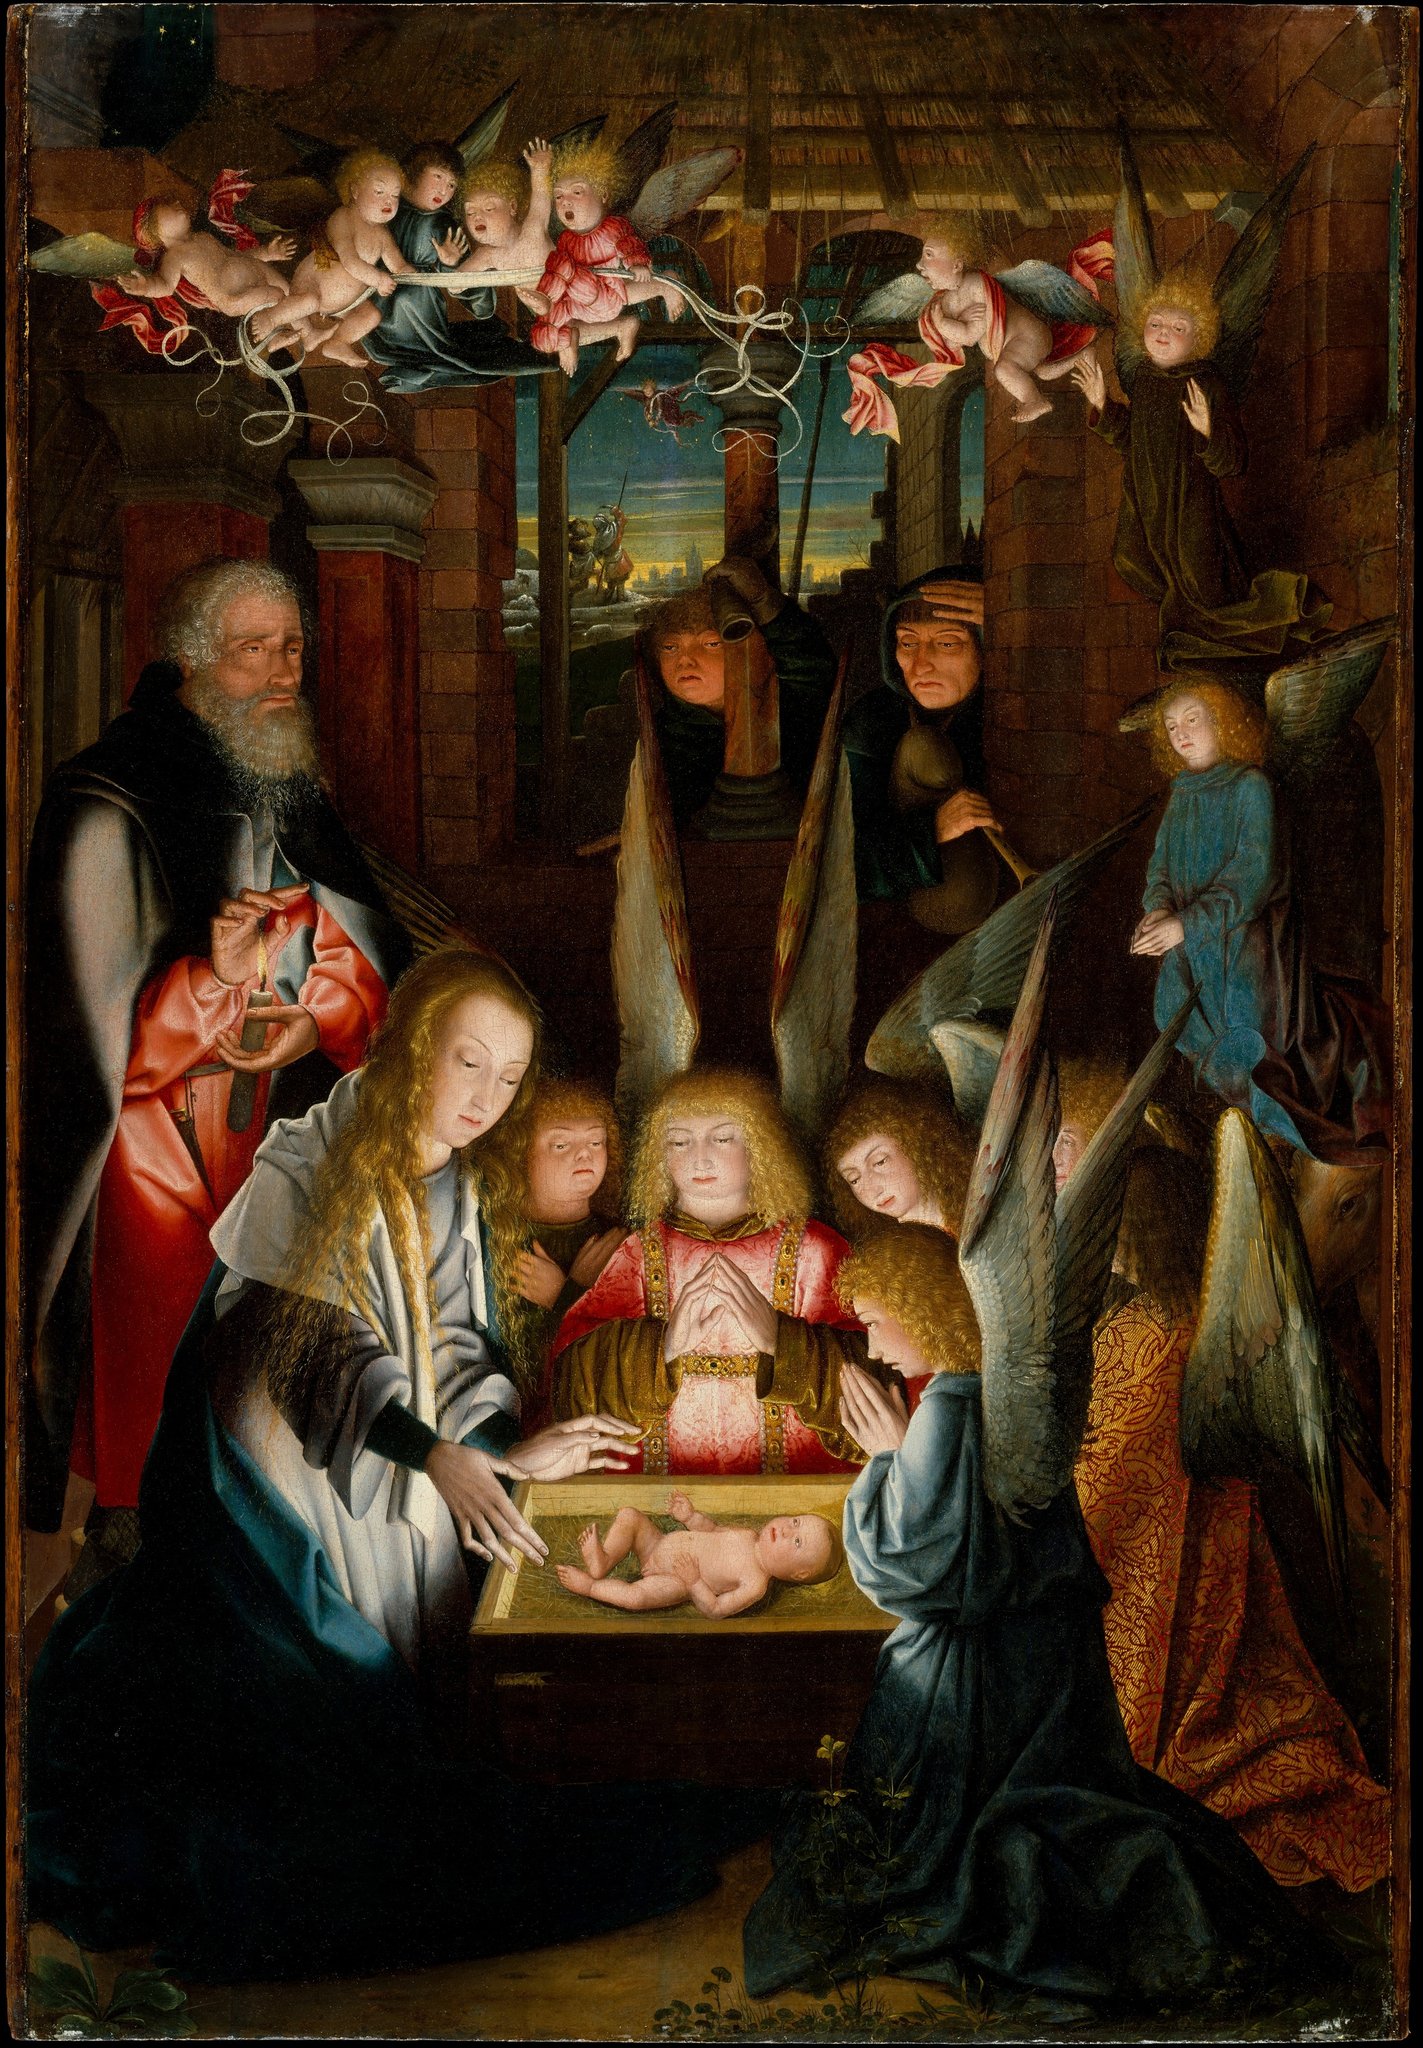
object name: painting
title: The Adoration of the Christ Child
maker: jan joest of kalkar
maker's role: artist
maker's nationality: german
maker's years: 1510-1520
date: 1510-1520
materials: oil, wood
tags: men,women,angels,virgin mary,jesus,adoration of the magi